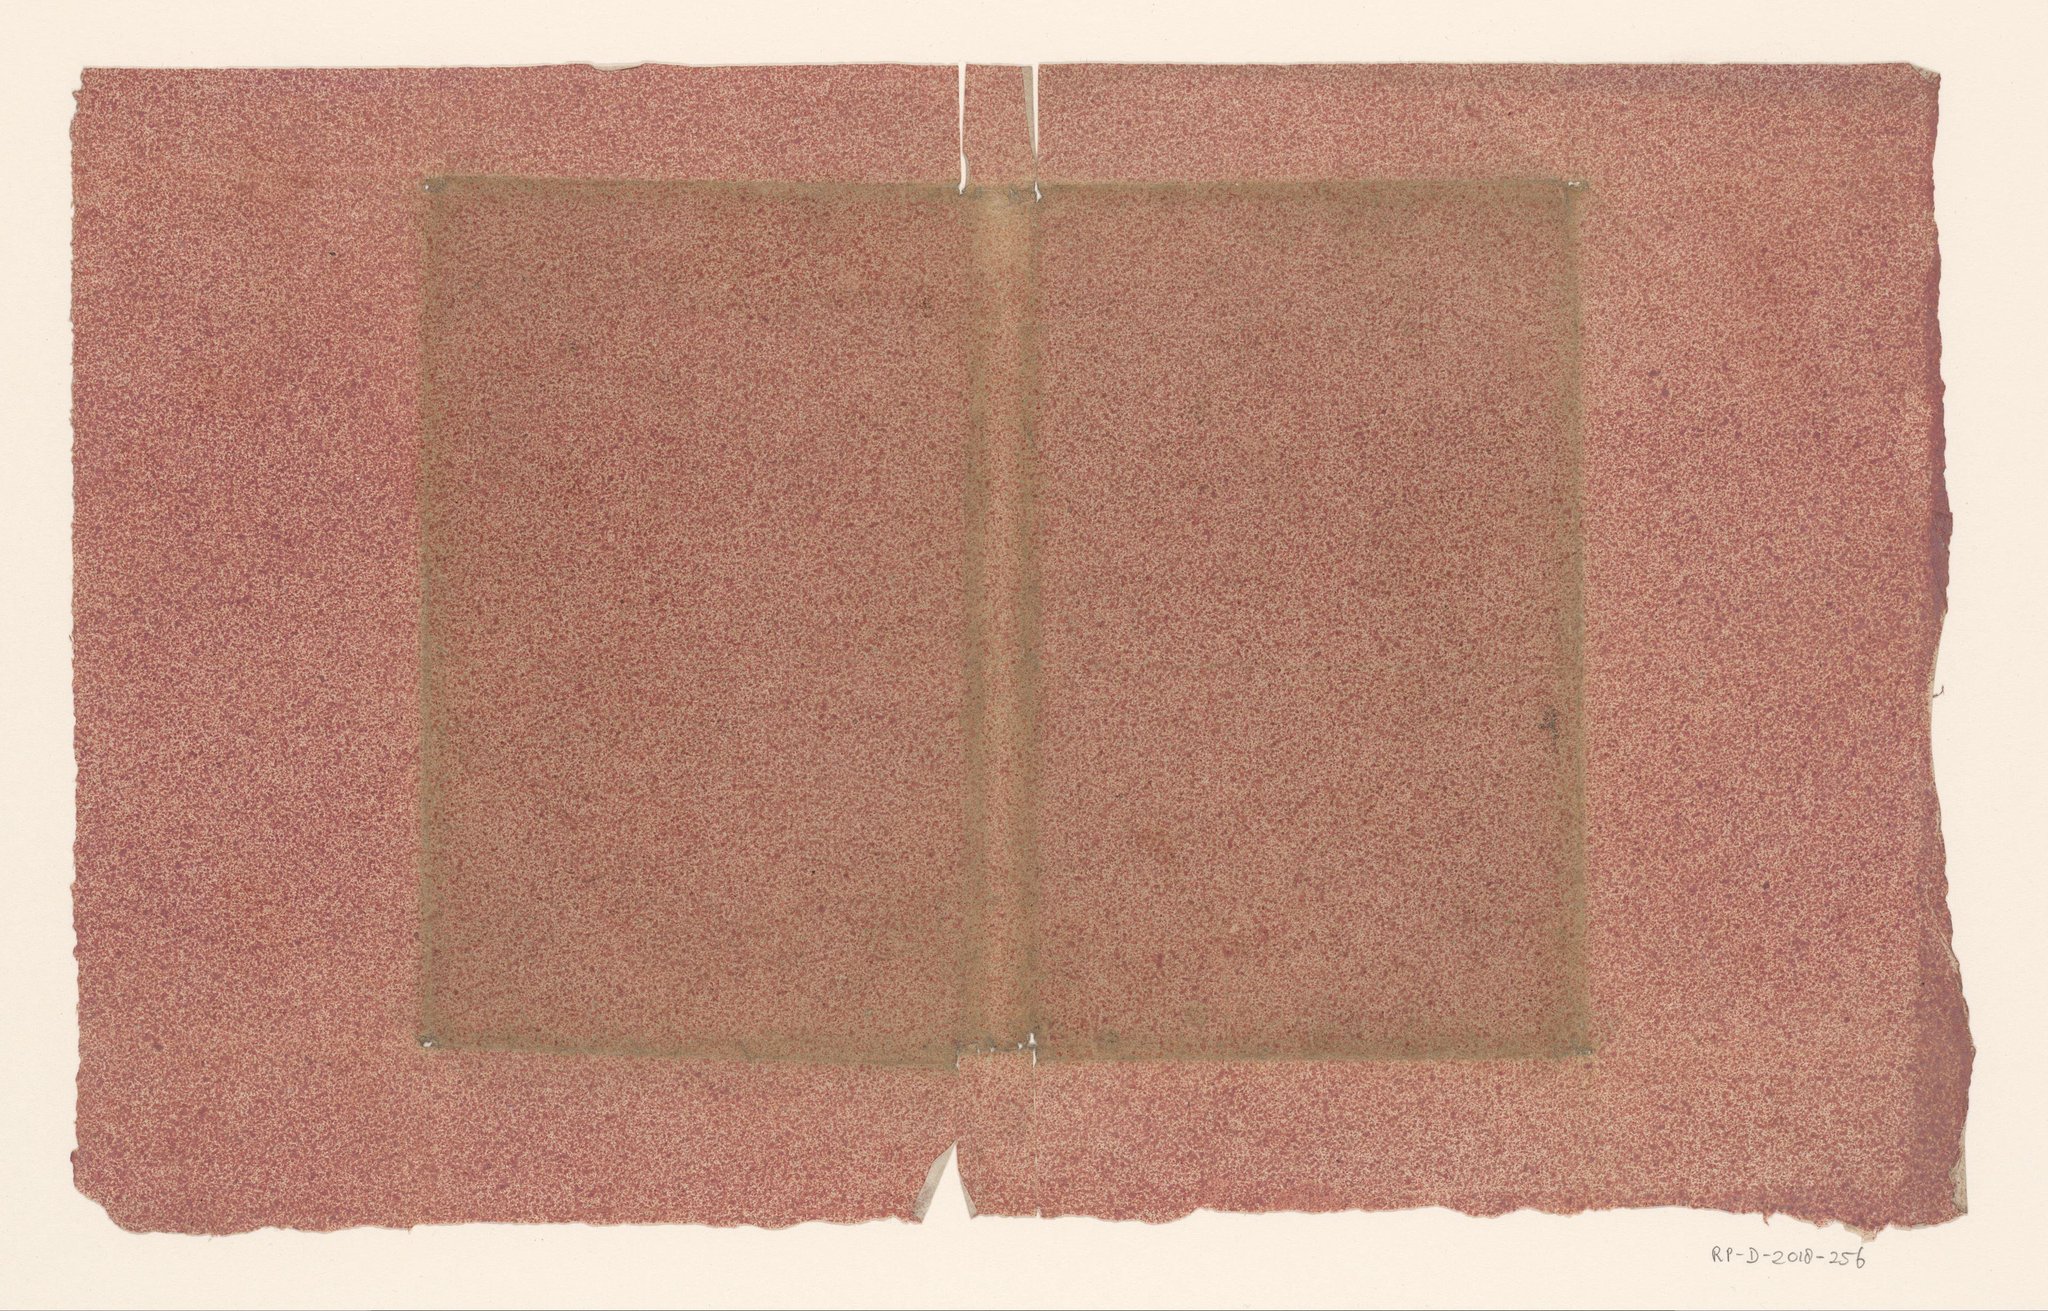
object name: sprinkled paper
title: Rood gespikkeld papier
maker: Anonymous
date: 1750-1900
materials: paint, paper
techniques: splatter marble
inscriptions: collector's mark: Lugt 2228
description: Rood gespikkeld papier. Gebruikt als omslag, met insnijdingen bij de rug.